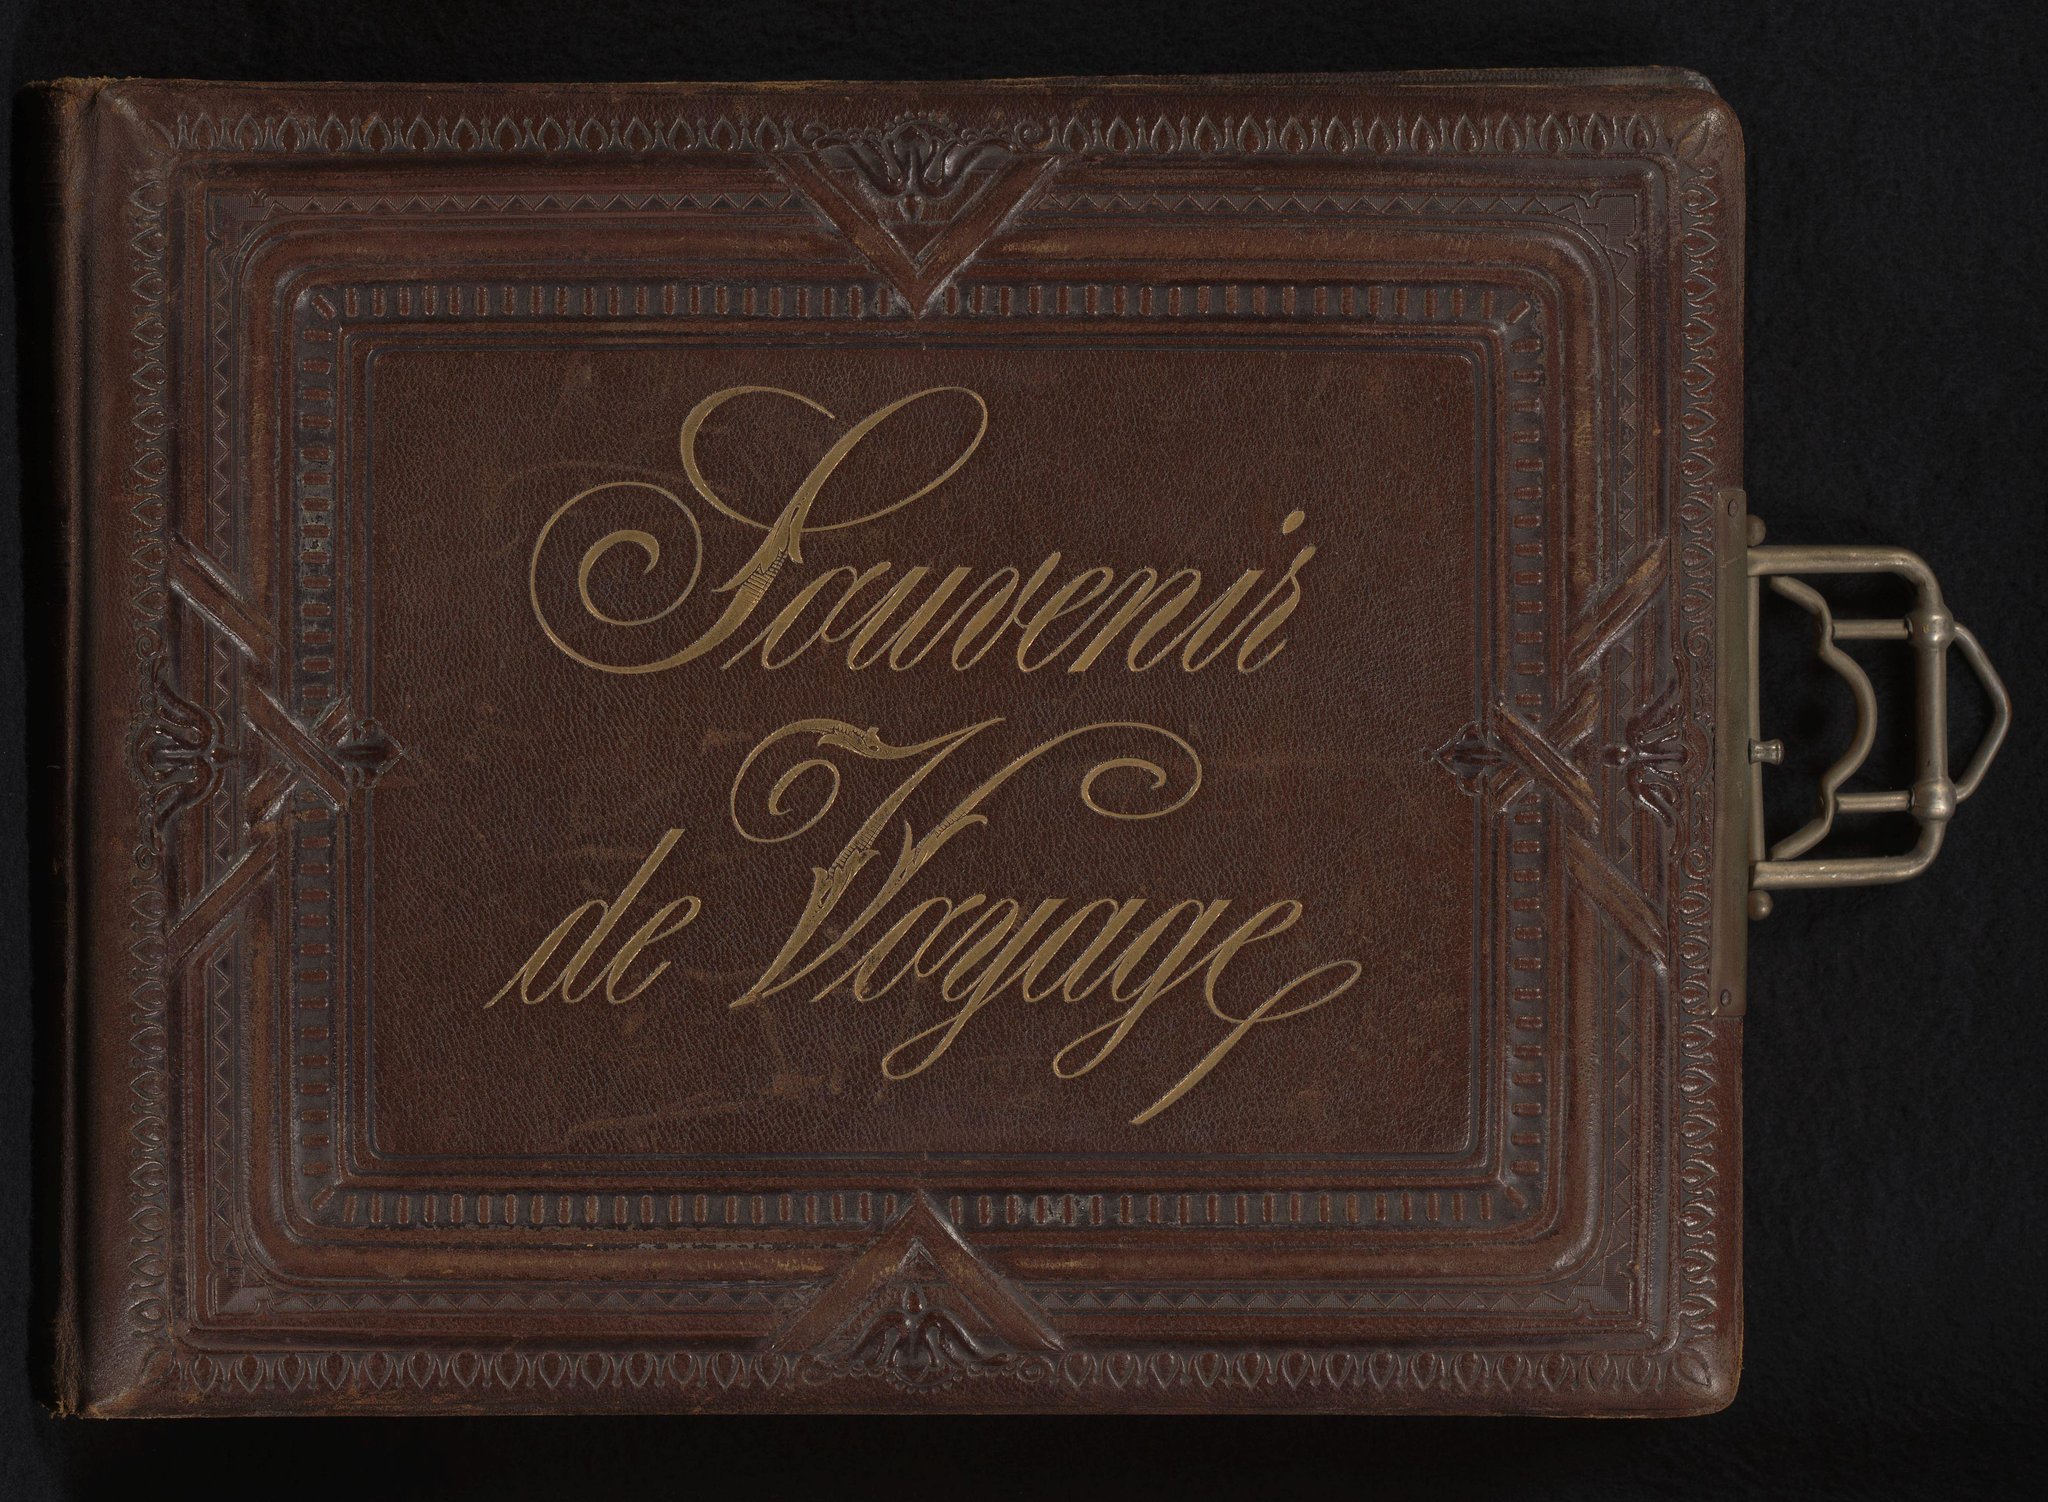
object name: slip in album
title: Fotoalbum (leeg)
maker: Anonymous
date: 1860-1900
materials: cardboard, leather, metal, paper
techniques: decorated paper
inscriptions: collector's mark: ‘DIENST/ VERSPREIDE/ RIJKSKOLLEKTIES/ (...) A 886’, inscription: ‘A. J. C. RIJK,/ Haarlem.’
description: Fotoalbum met 28 pagina's met ieder een met gouden lijnen omkaderde liggende passe-partout voor een kabinetfoto.